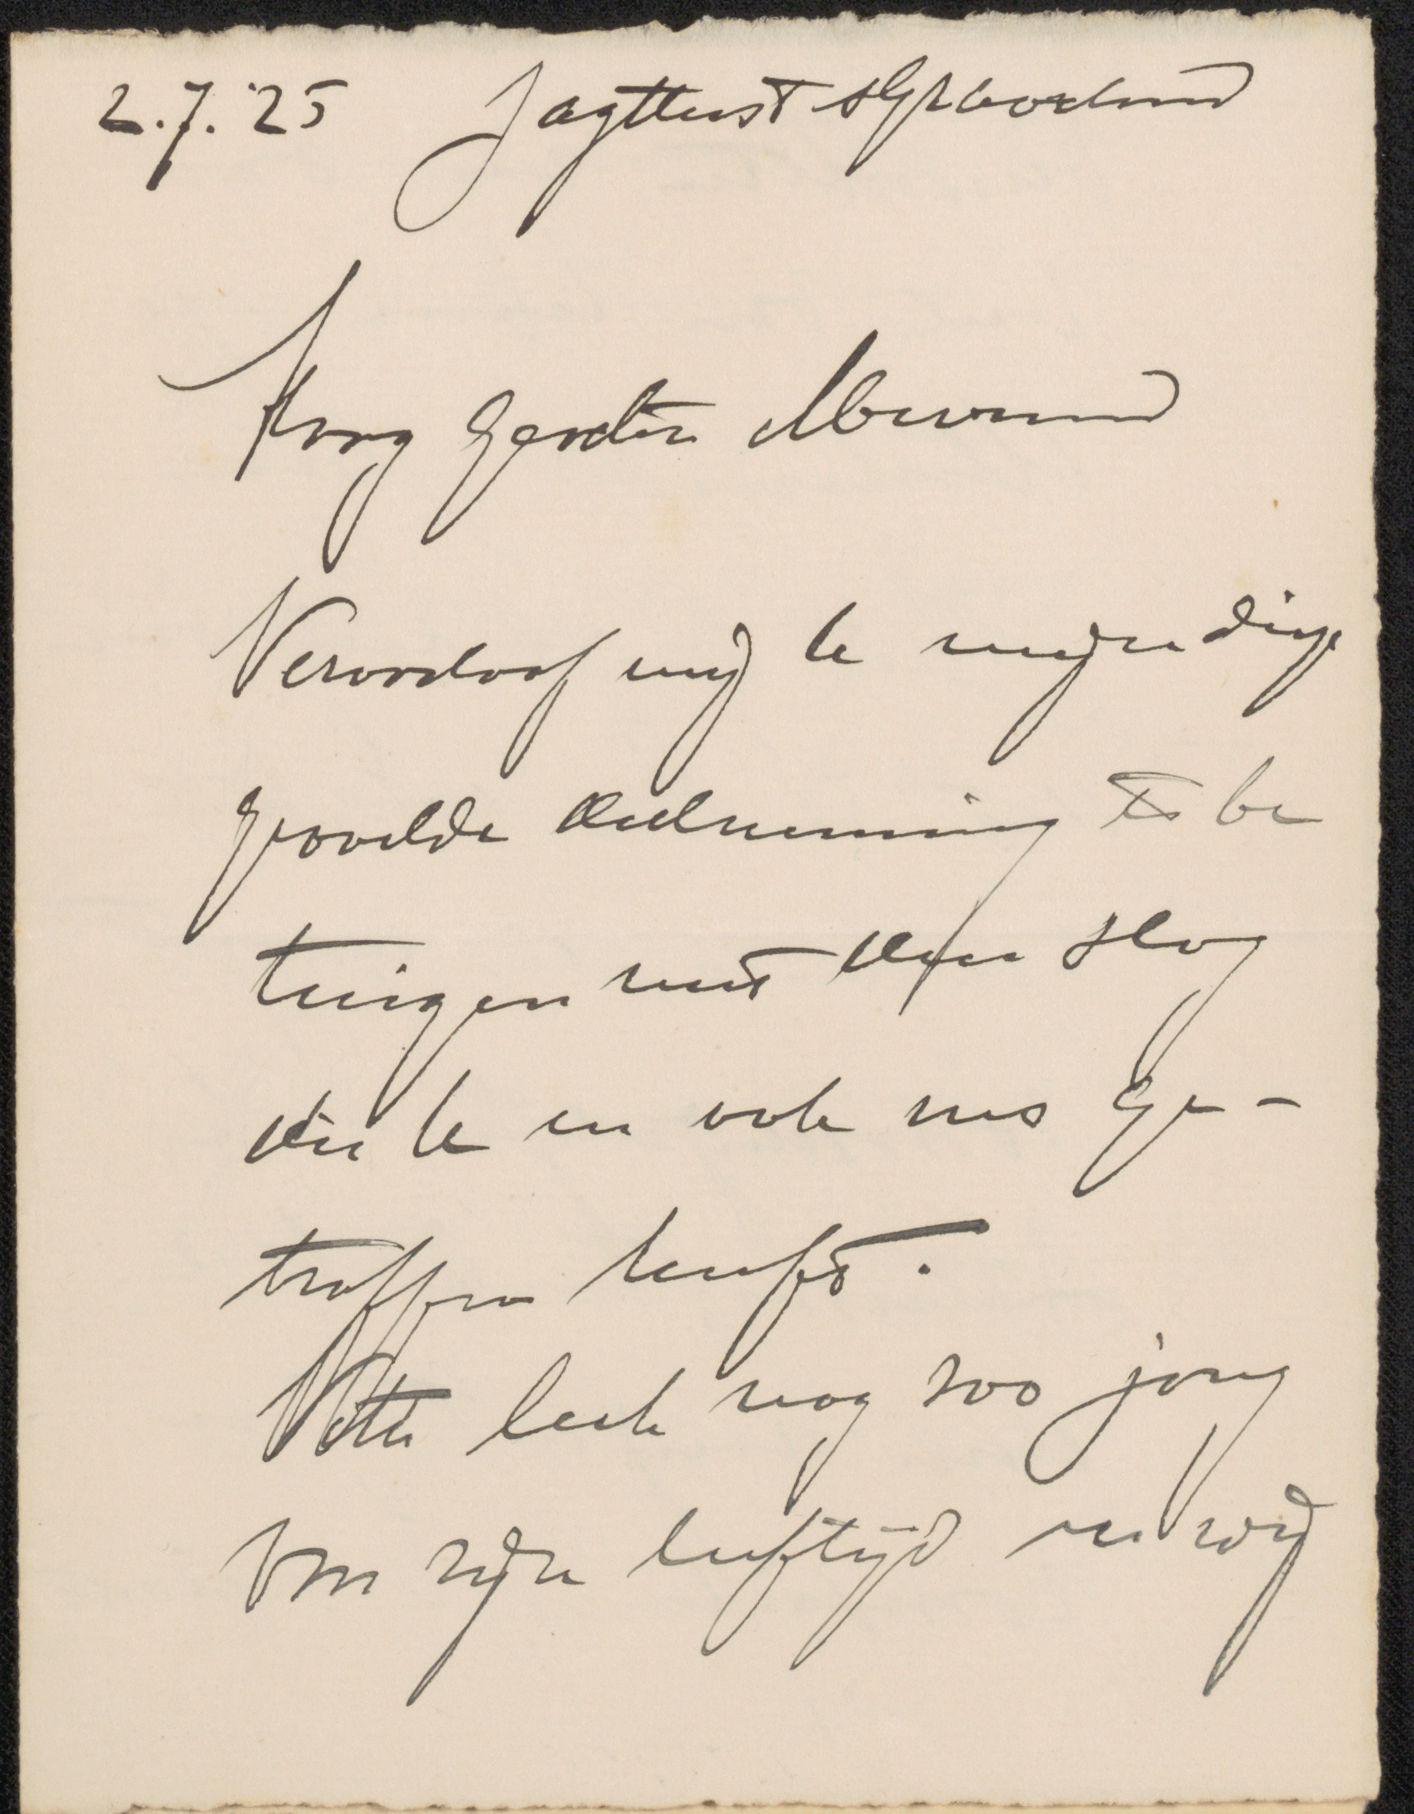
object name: letter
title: Brief aan Anna Dorothea Dirks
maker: jonkheer jan six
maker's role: hoogleraar, kunsthistoricus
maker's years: 1857-1926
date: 1925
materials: ink, paper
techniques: pen, writing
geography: hilversum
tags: painter, draughtsman, designer, jan veth, artist, anna dorothea dirks, family life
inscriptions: watermark, collector's mark: ‘RPK’